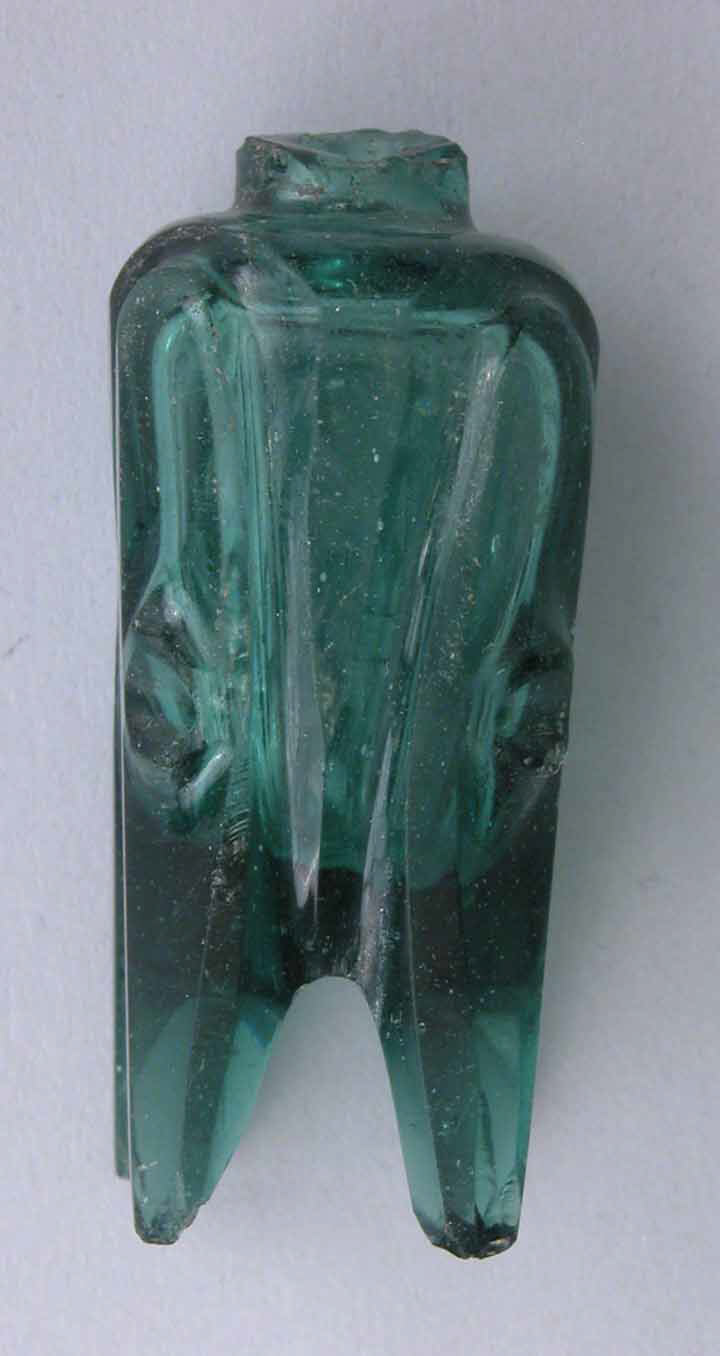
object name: bottle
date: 801-1100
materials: glass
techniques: cutting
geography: egypt